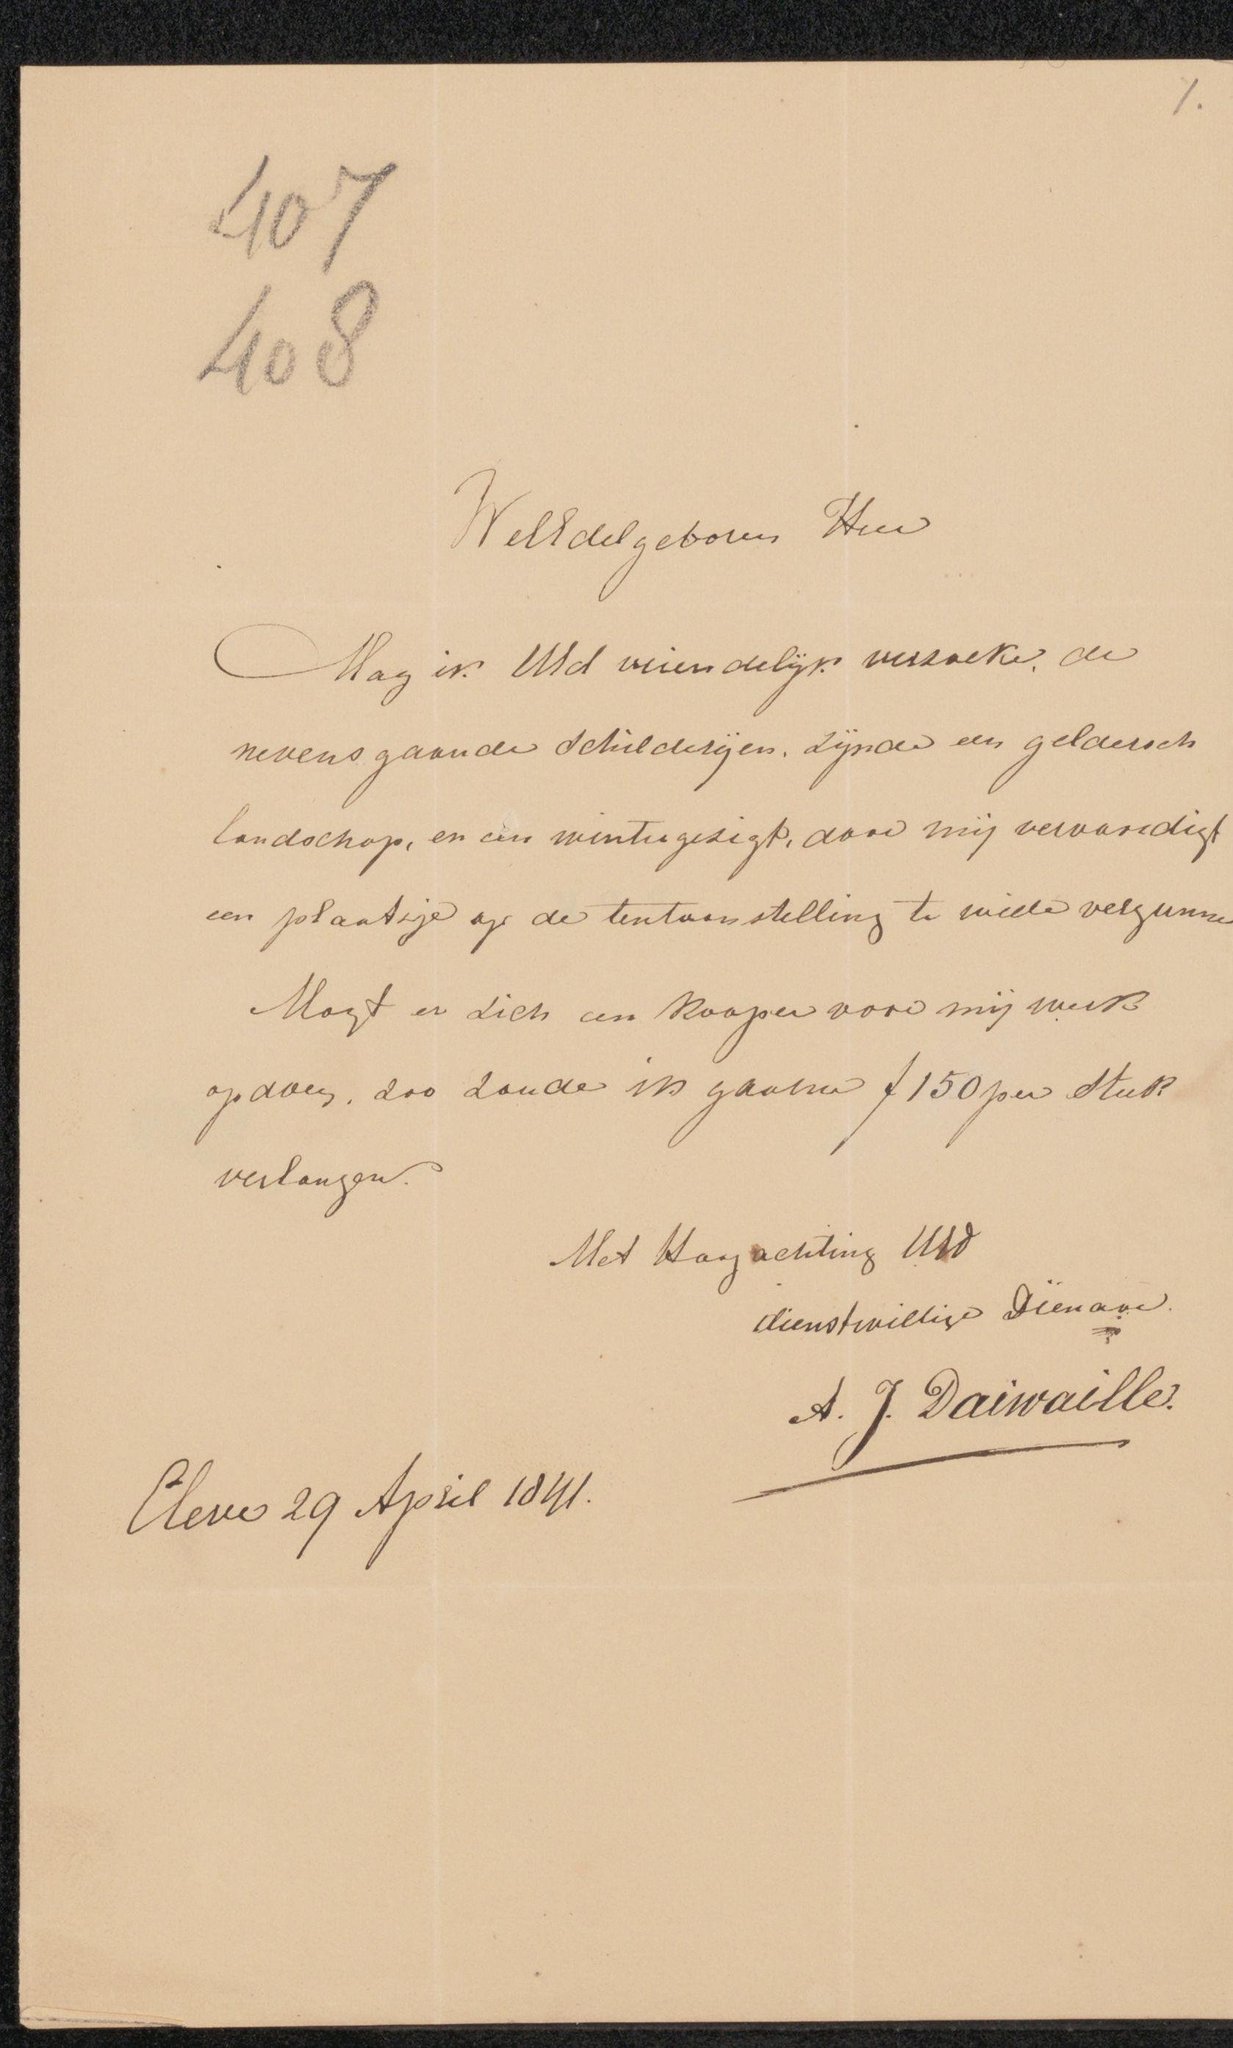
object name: letter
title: Brief aan G.M.C. Hooft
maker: alexander joseph daiwaille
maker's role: print maker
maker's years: 1818-1888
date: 1841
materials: ink, paper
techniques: pen, writing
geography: cleves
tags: painting (including book-illumination, miniature-painting), exhibition ~ art, money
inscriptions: seal, collector's mark: Lugt 2233